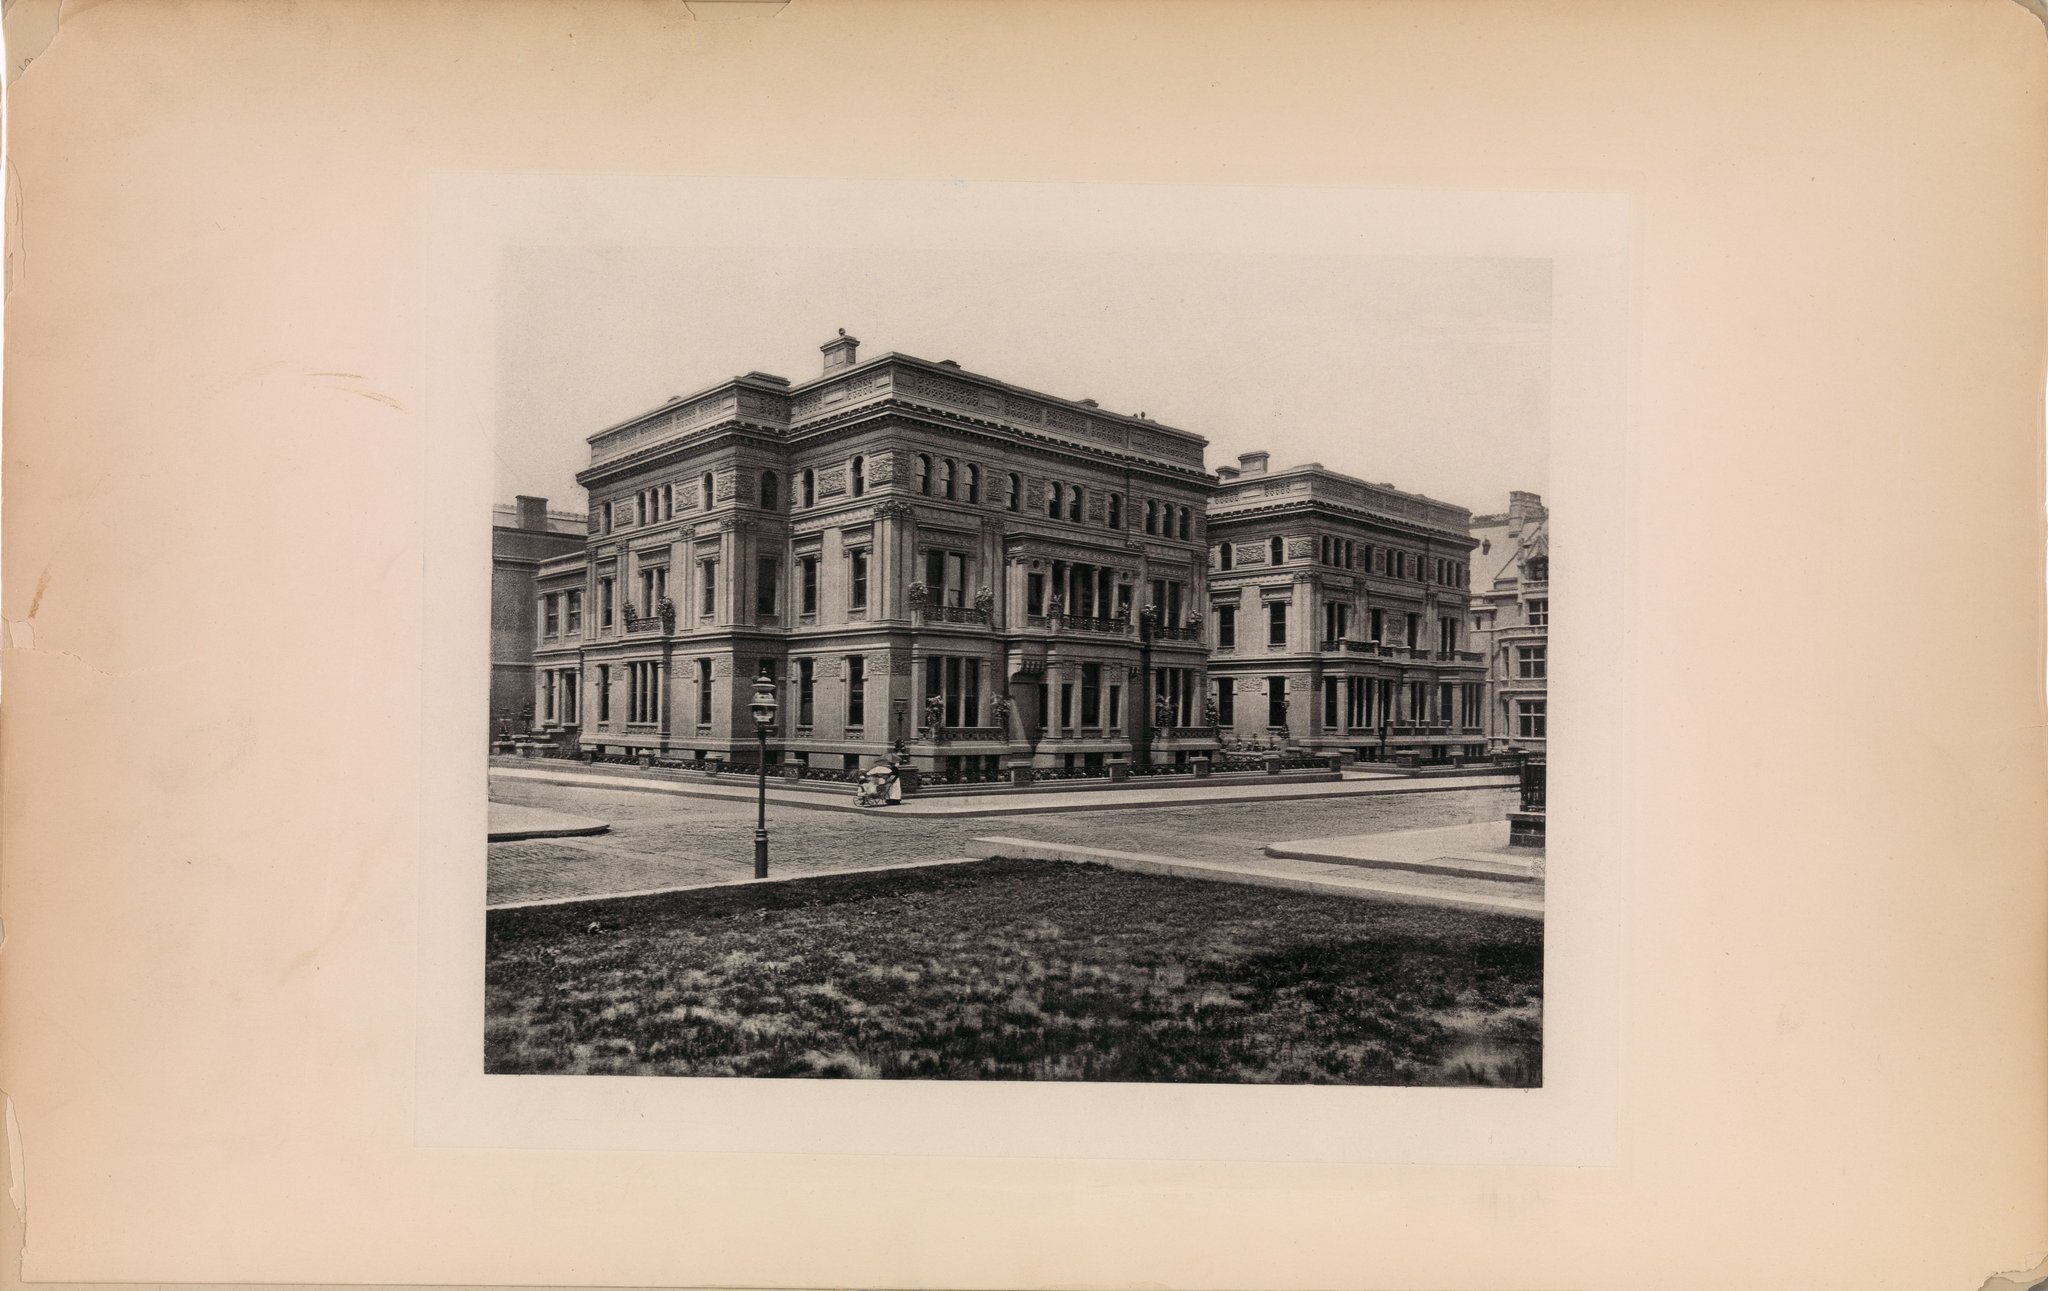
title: Mr. Vanderbilt's house and collection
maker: edward strahan (earl shinn)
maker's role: author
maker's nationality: american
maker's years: 1838-1886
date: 1883-1884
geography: boston